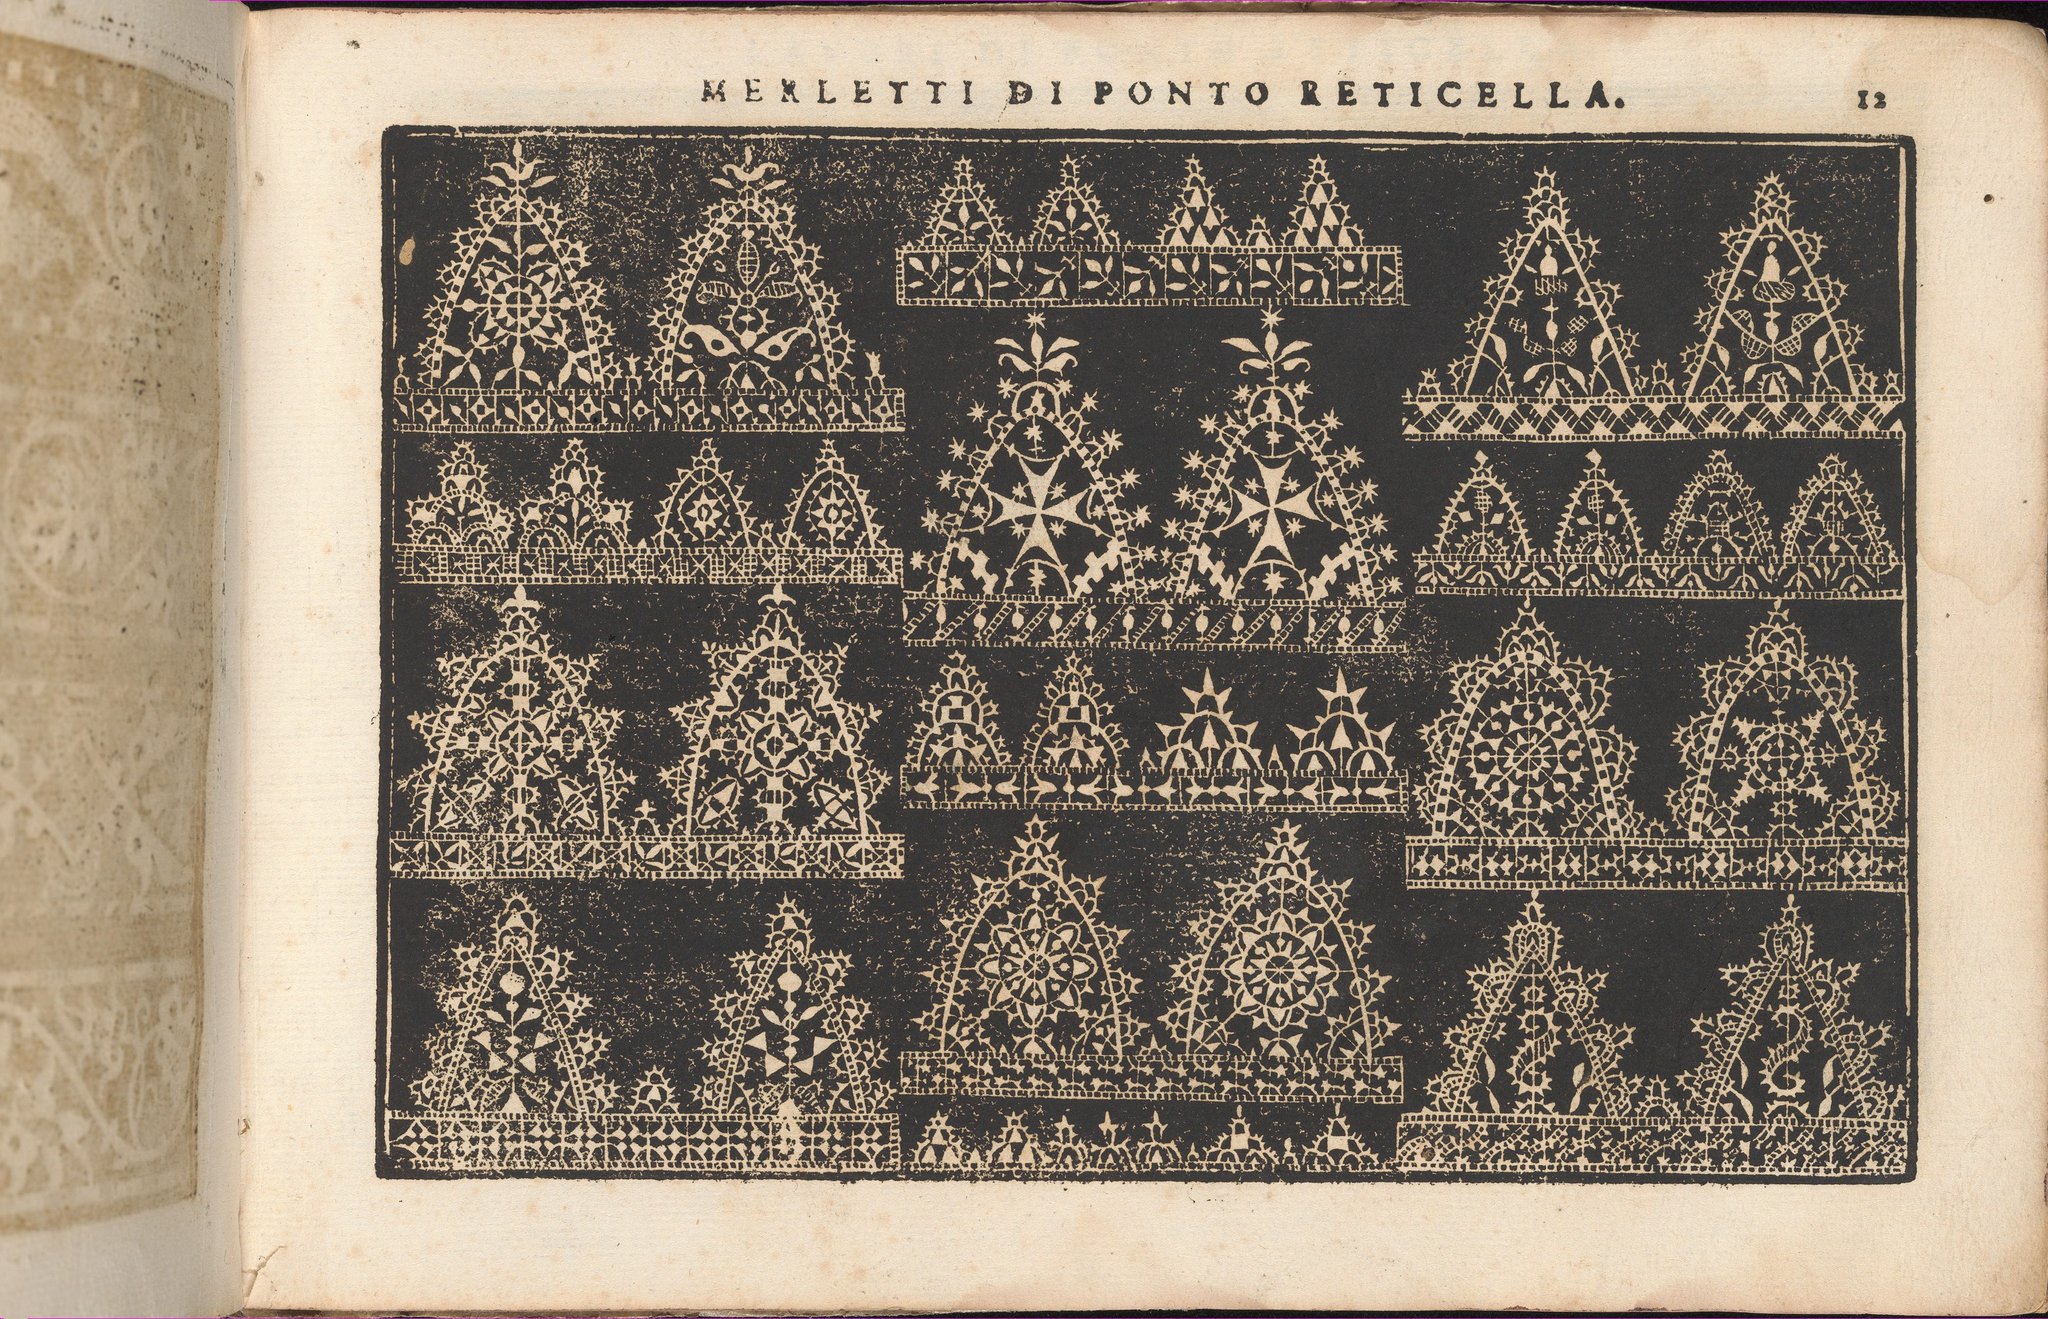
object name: book print ornament architecture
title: Teatro delle Nobili et Virtuose Donne..., page 8 (recto)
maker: isabella catanea parasole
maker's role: author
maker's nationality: italian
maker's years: 1565-1625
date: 1616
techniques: engraving, woodcut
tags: flowers